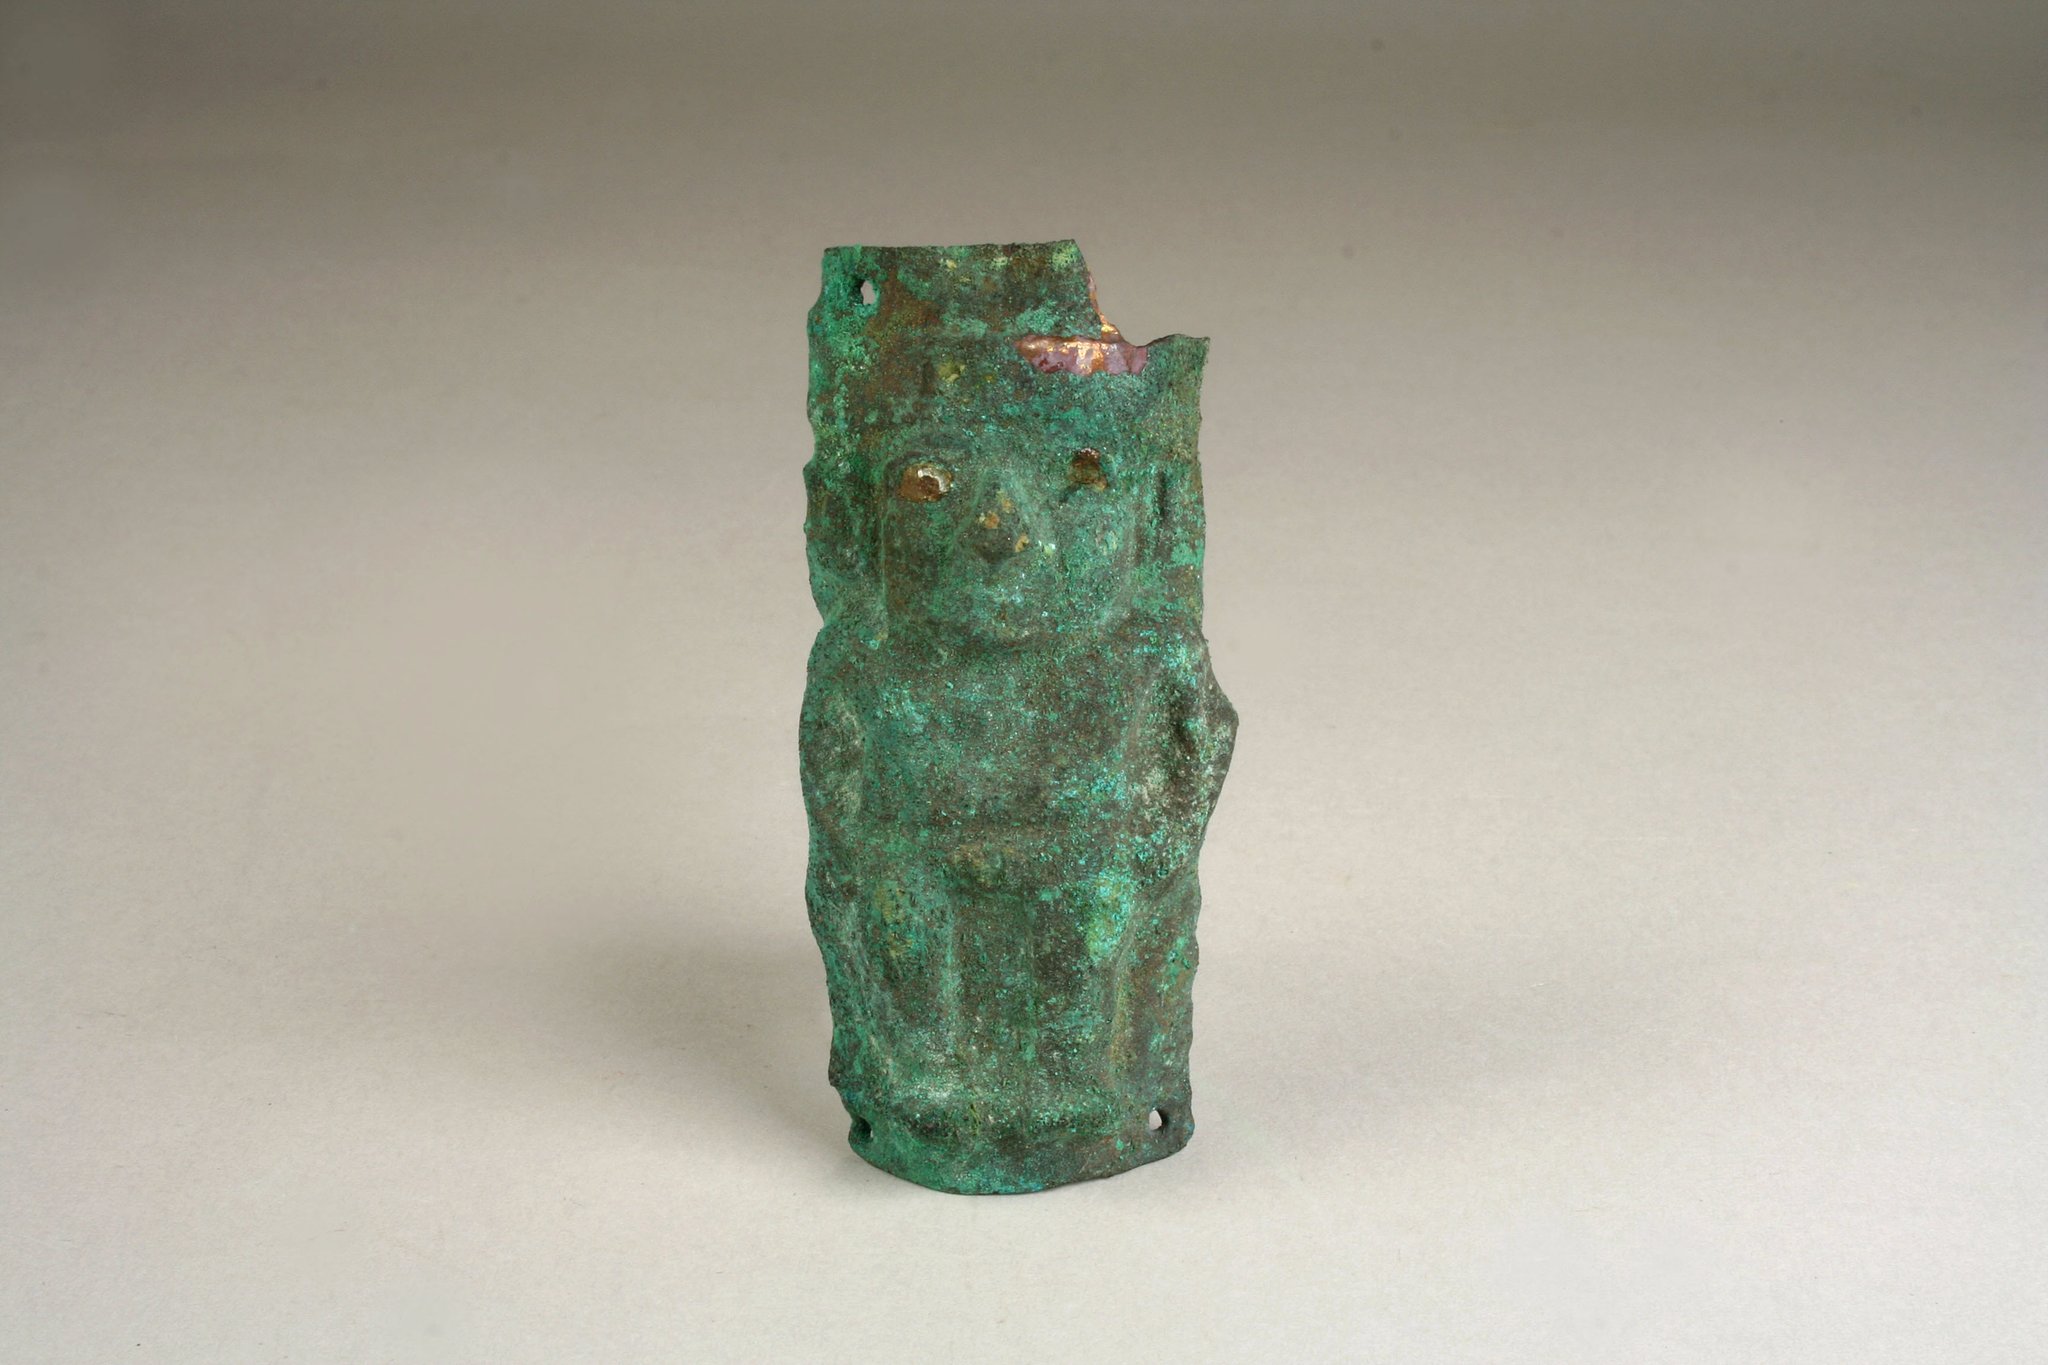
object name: staff head fragment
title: Staff Head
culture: moche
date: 501-700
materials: copper, stone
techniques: gilding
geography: peru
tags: heads